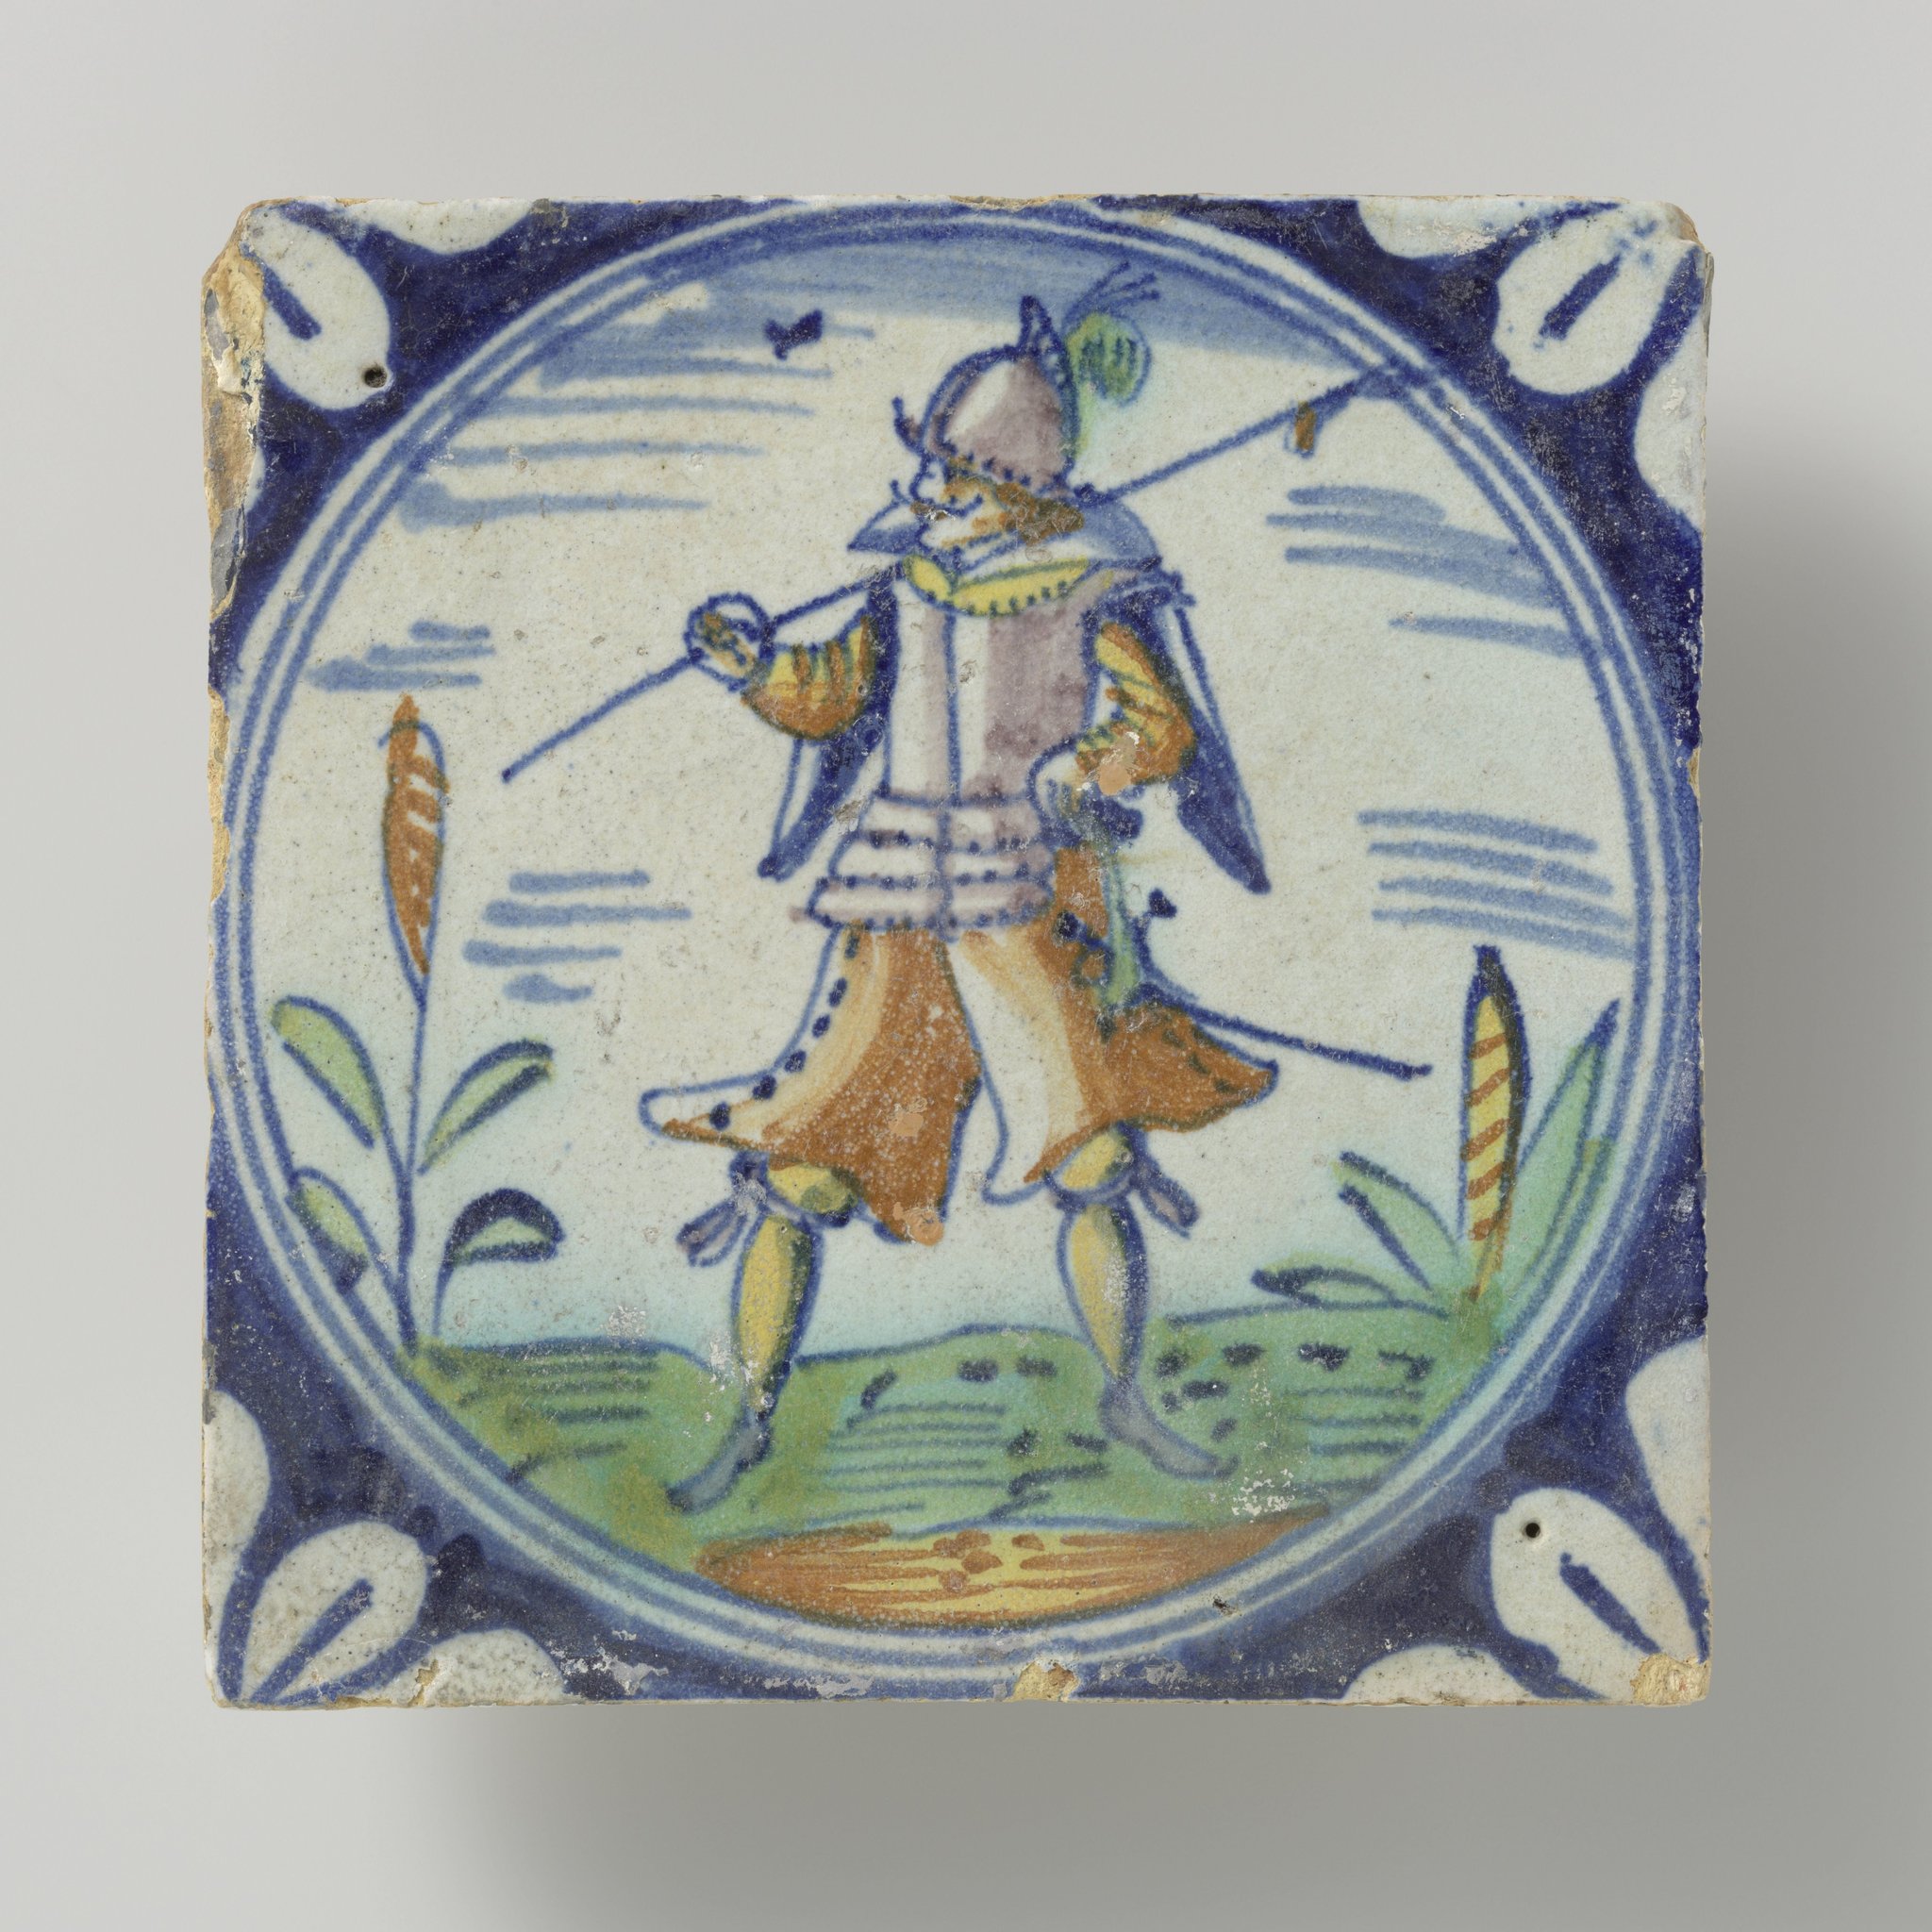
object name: tile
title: Tegel, veelkleurig beschilderd met een soldaat of een vaandeldrager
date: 1625-1700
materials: earthenware, glaze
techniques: maiolica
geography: netherlands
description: Tegel, veelkleurig beschilderd met een soldaat of een vaandeldrager.